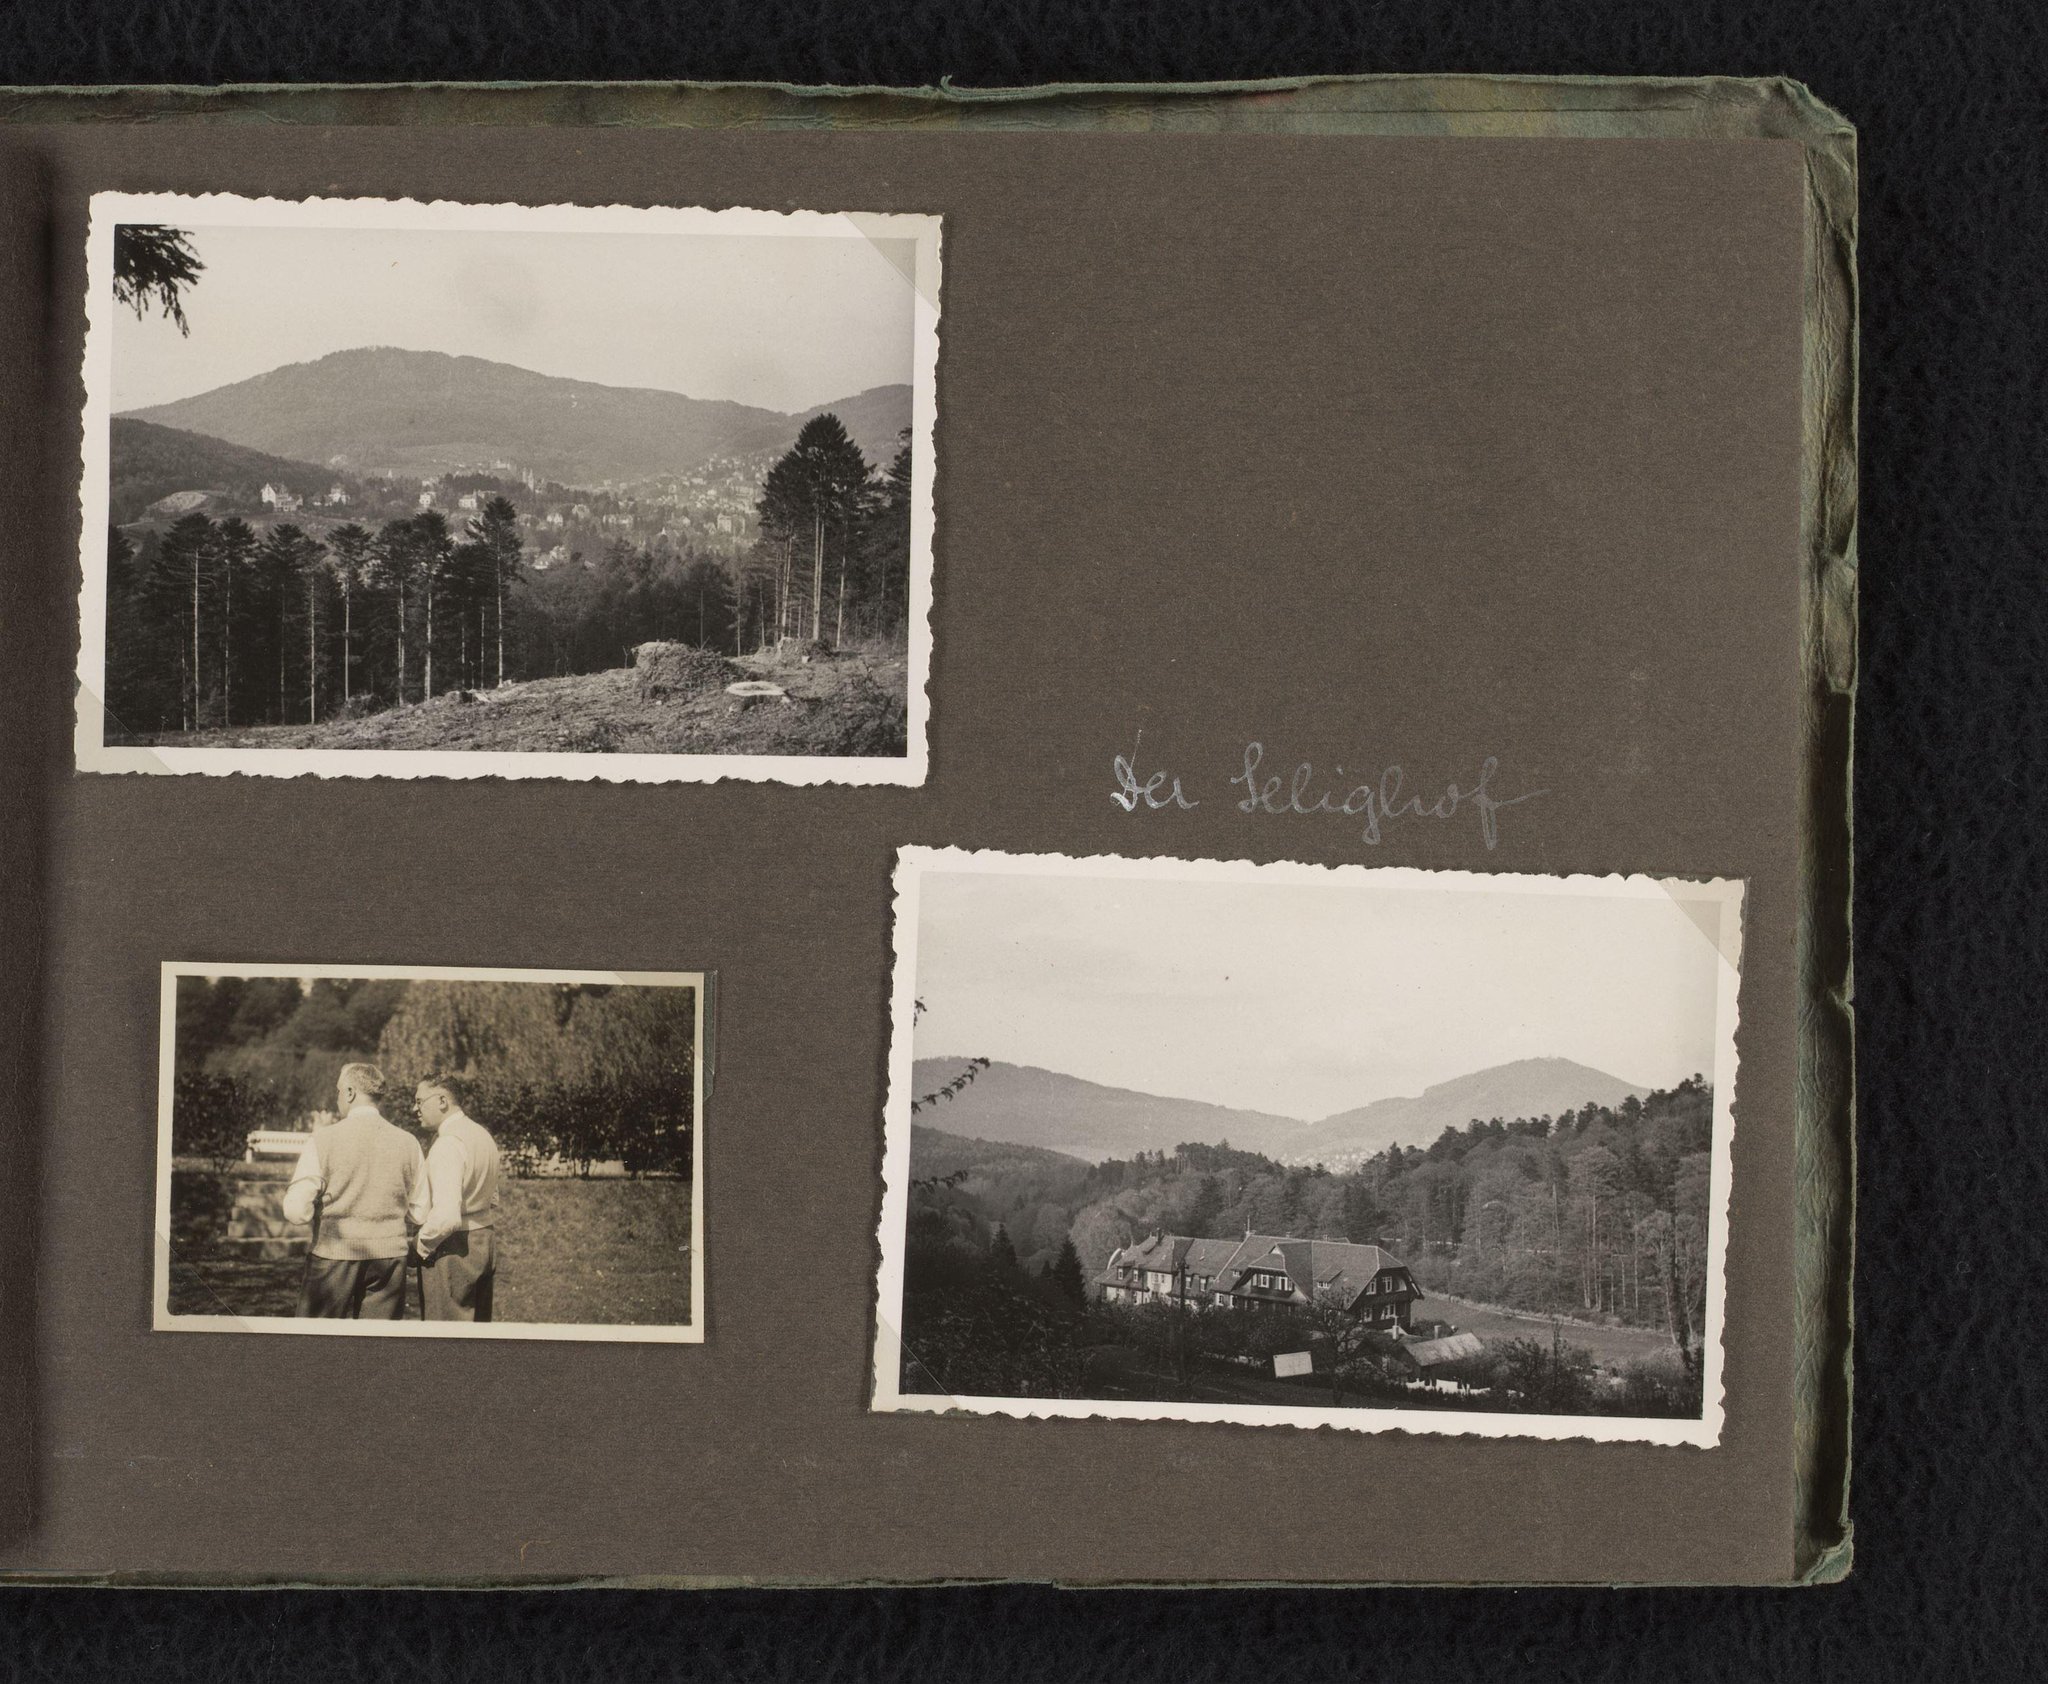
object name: album leaf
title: Blik op en vanaf hotel Selighof, en Eugen Wachenheimer aan het praten met oom Stephan, april 1933, Baden-Baden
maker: else wachenheimer-moos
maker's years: 1895-1944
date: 1904-1933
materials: paper, photographic support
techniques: gelatin silver print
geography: baden-baden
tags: eugen wachenheimer, the family travelling, on holiday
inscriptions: inscription: ‘Der Selighof’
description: Blad bevat drie foto's. Alle foto's van Eugen Wachenheimer (links) en oom Stephan (rechts). Uit het album, half formaat, groen geaderd kartonomslag met koordbinding.